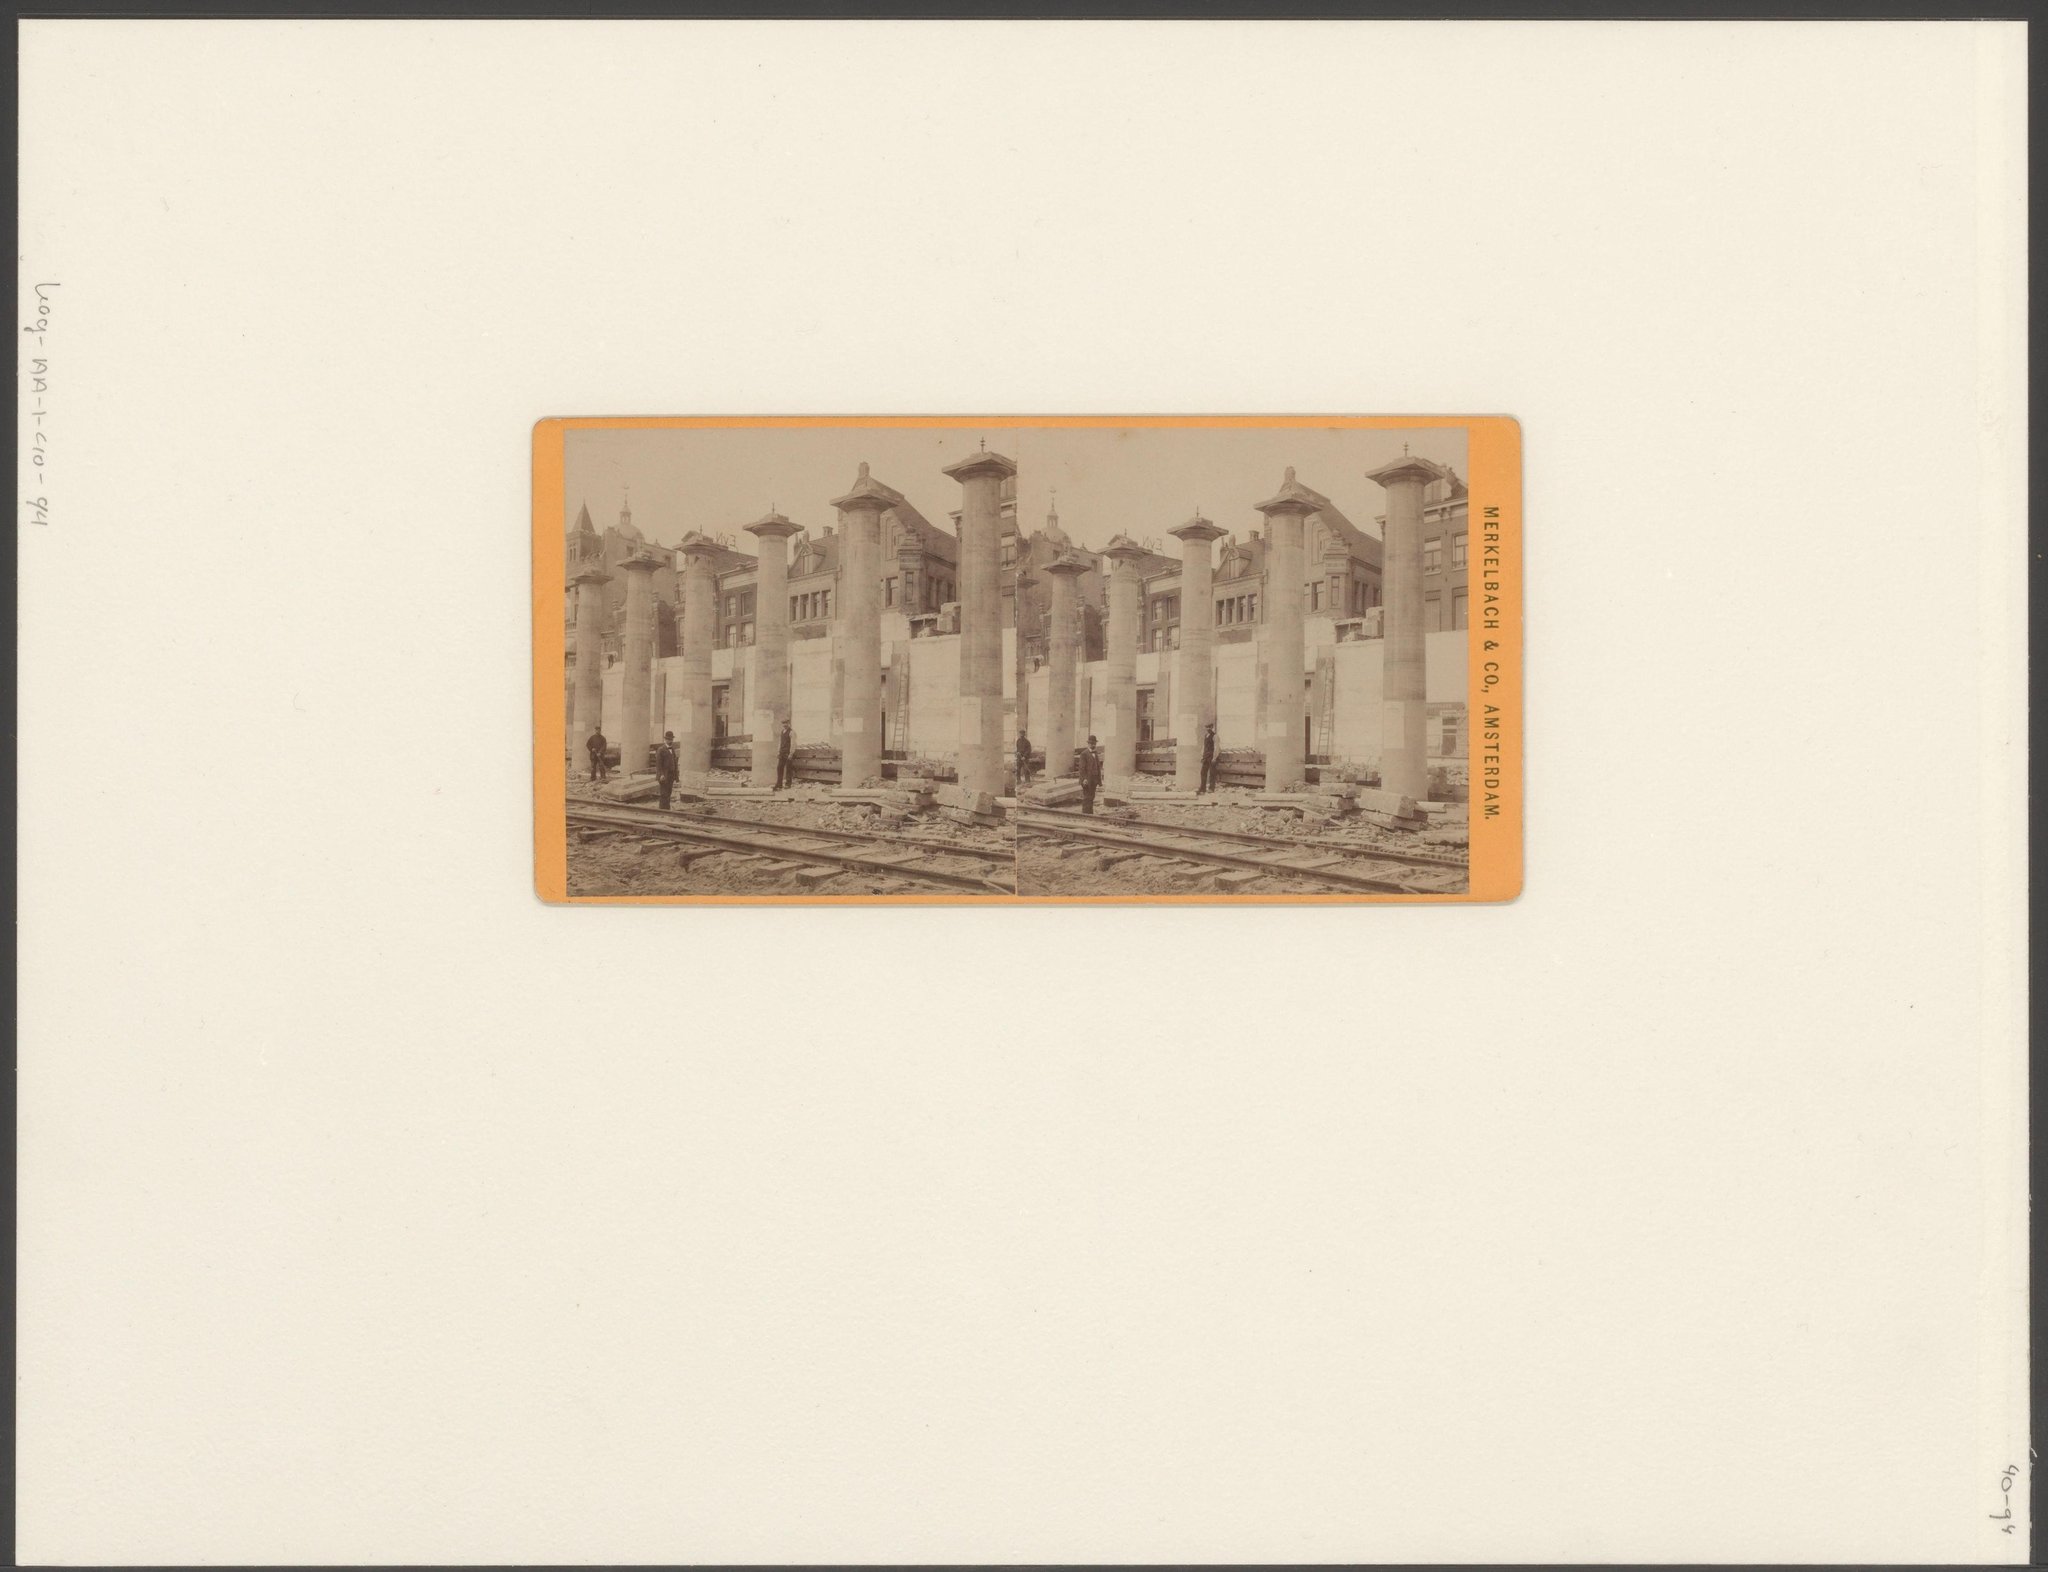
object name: photograph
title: Zuilen van de Beurs van Zocher te Amsterdam tijdens de afbraak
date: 1903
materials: cardboard, paper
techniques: albumen print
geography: amsterdam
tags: column, pillar ~ architecture, stock exchange, stock-market, demolition of building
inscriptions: inscription: ‘ J.D. 1904 ’, collector's mark: Lugt 1641b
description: Onderwerpsrubriek binnen de Atlas Amsterdam: Handel en Zeevaart: Hulpbeurs op de Dam en Beurs (Dam).